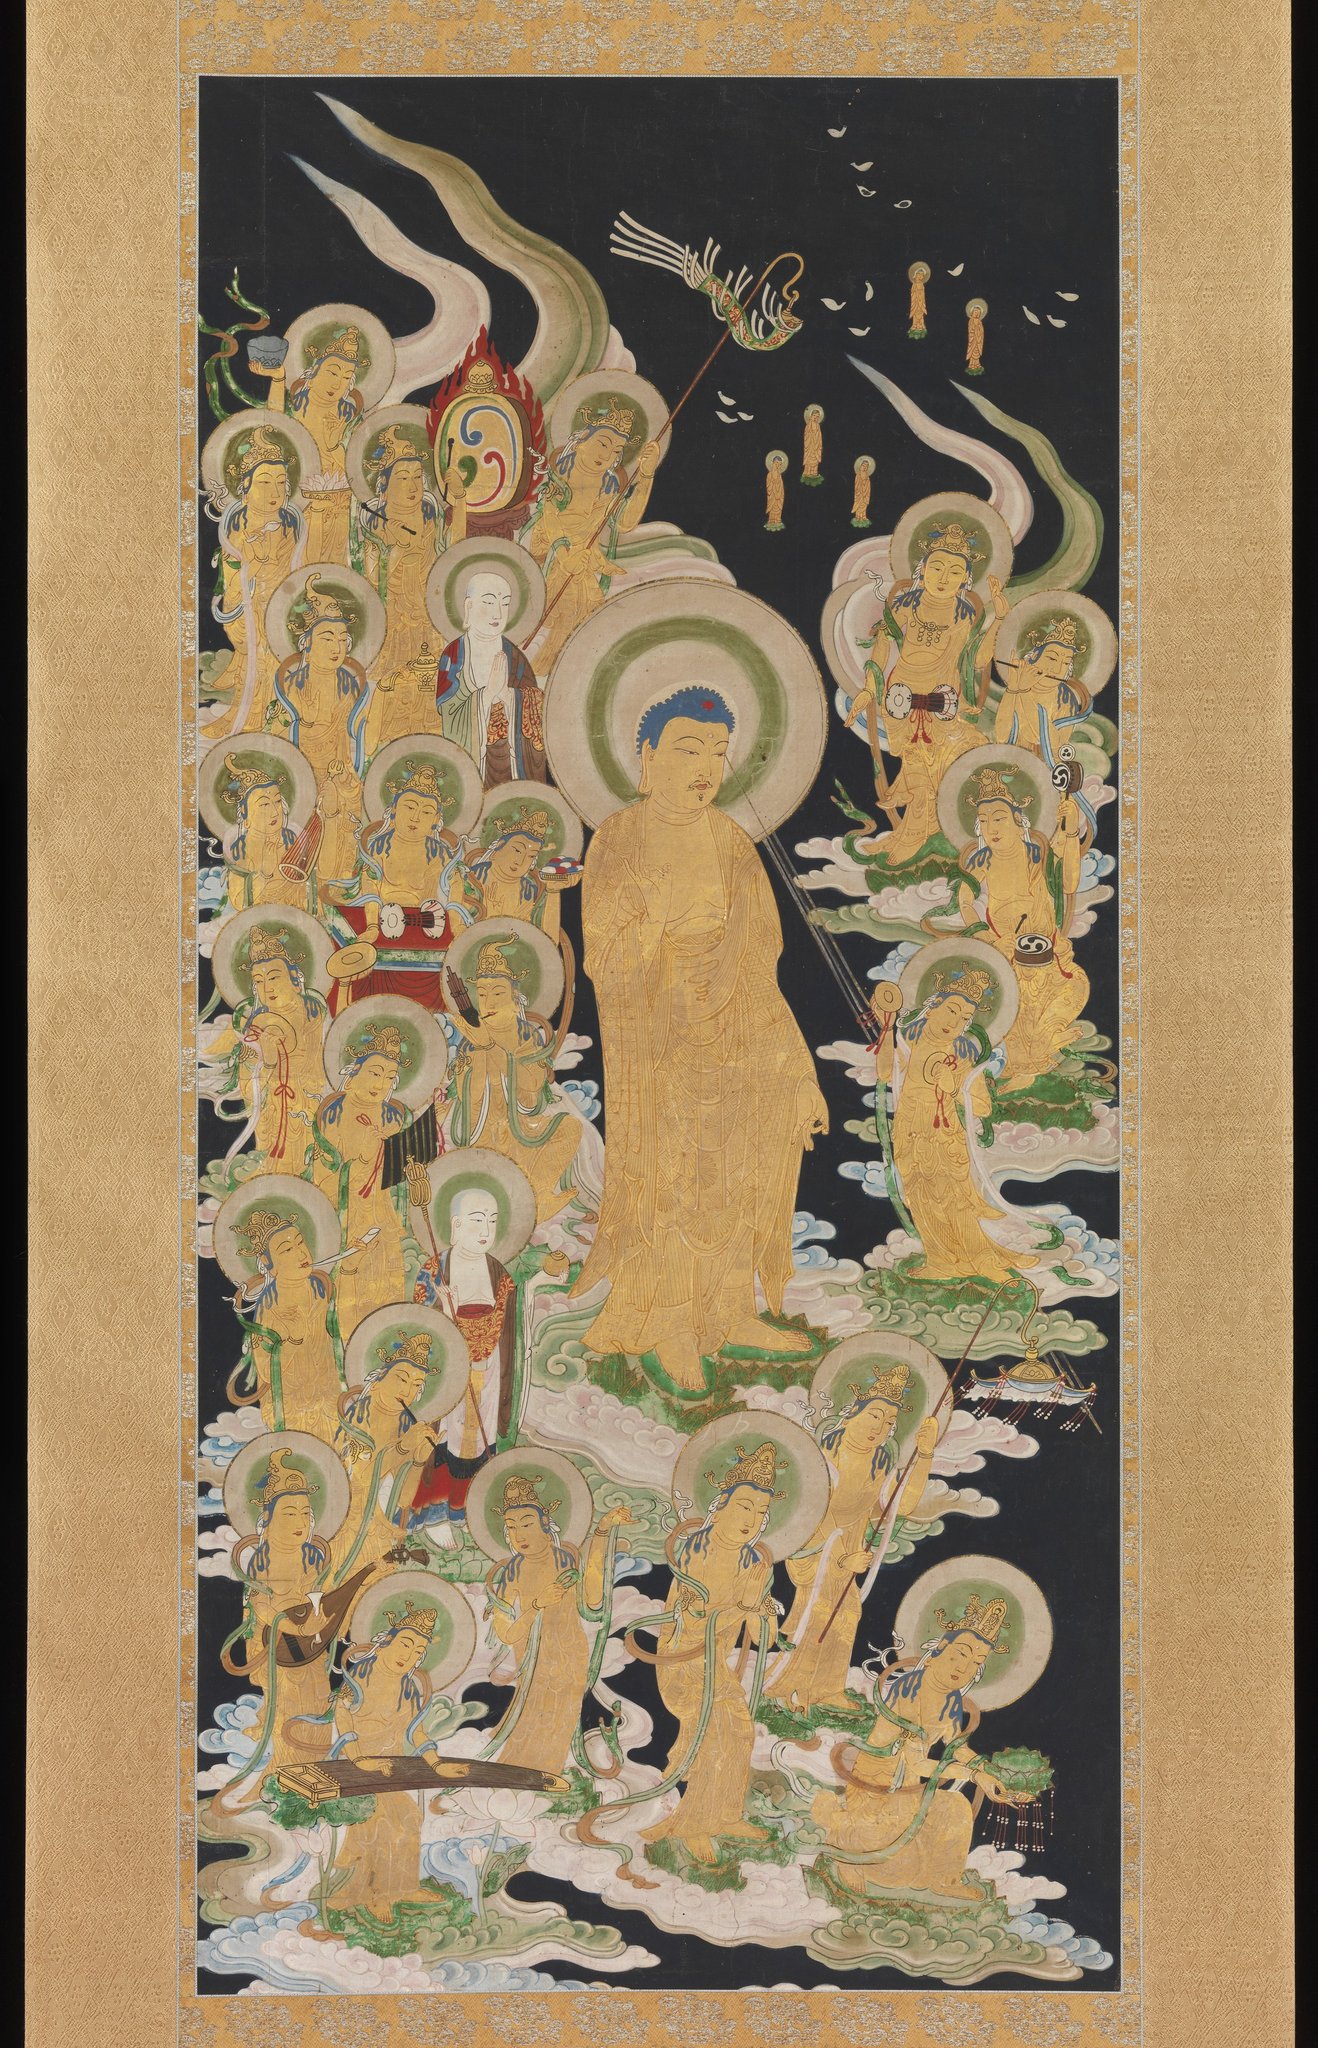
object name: hanging scroll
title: Buddha and Attendants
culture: japanese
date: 1601-1800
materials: ink, paper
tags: buddhism,buddha